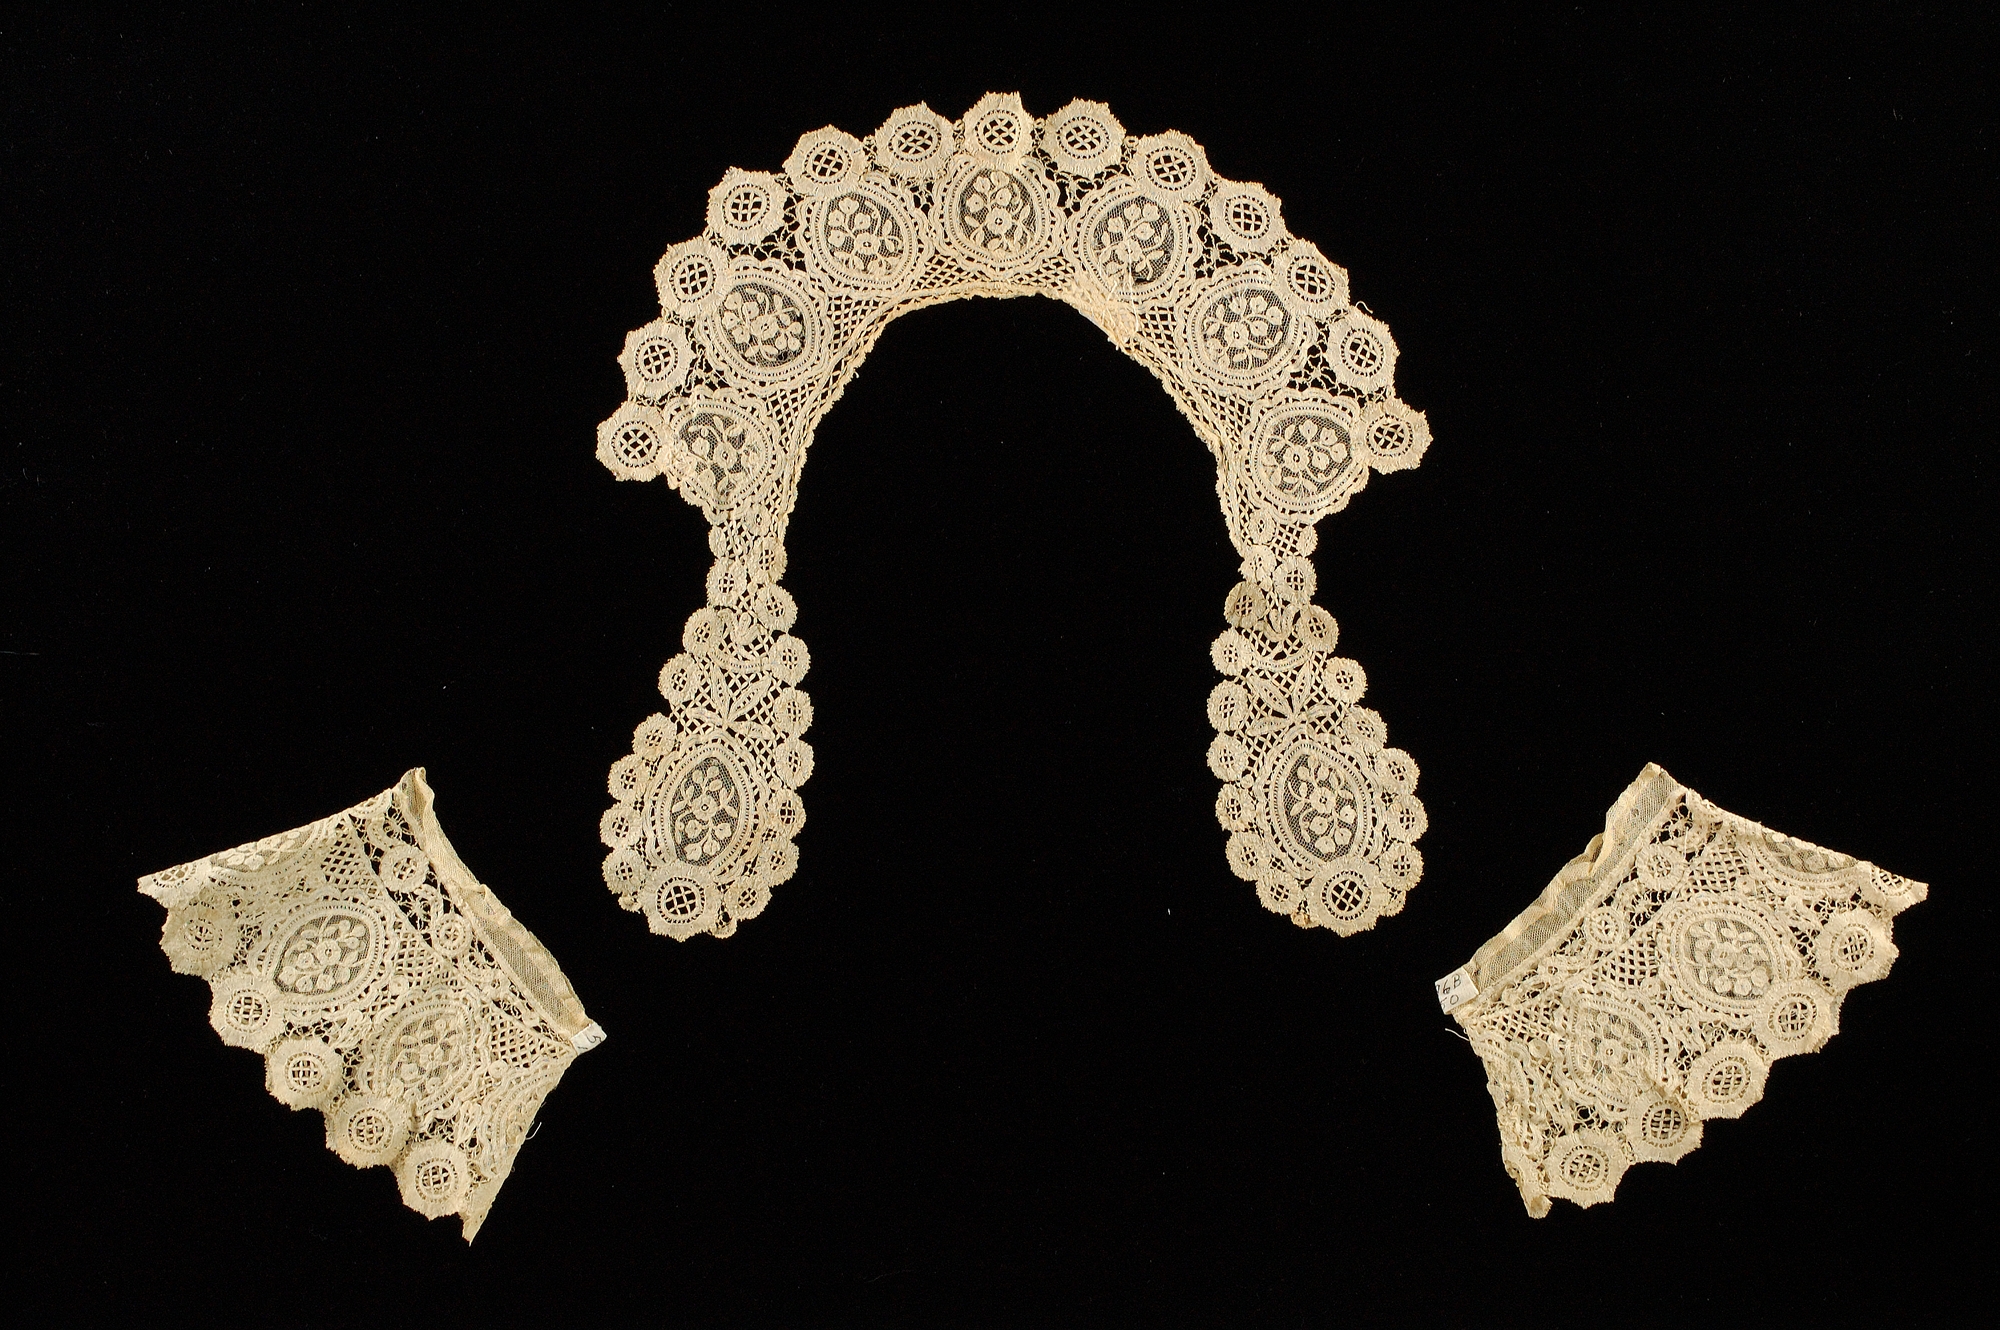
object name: accessory set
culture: british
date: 1850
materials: linen